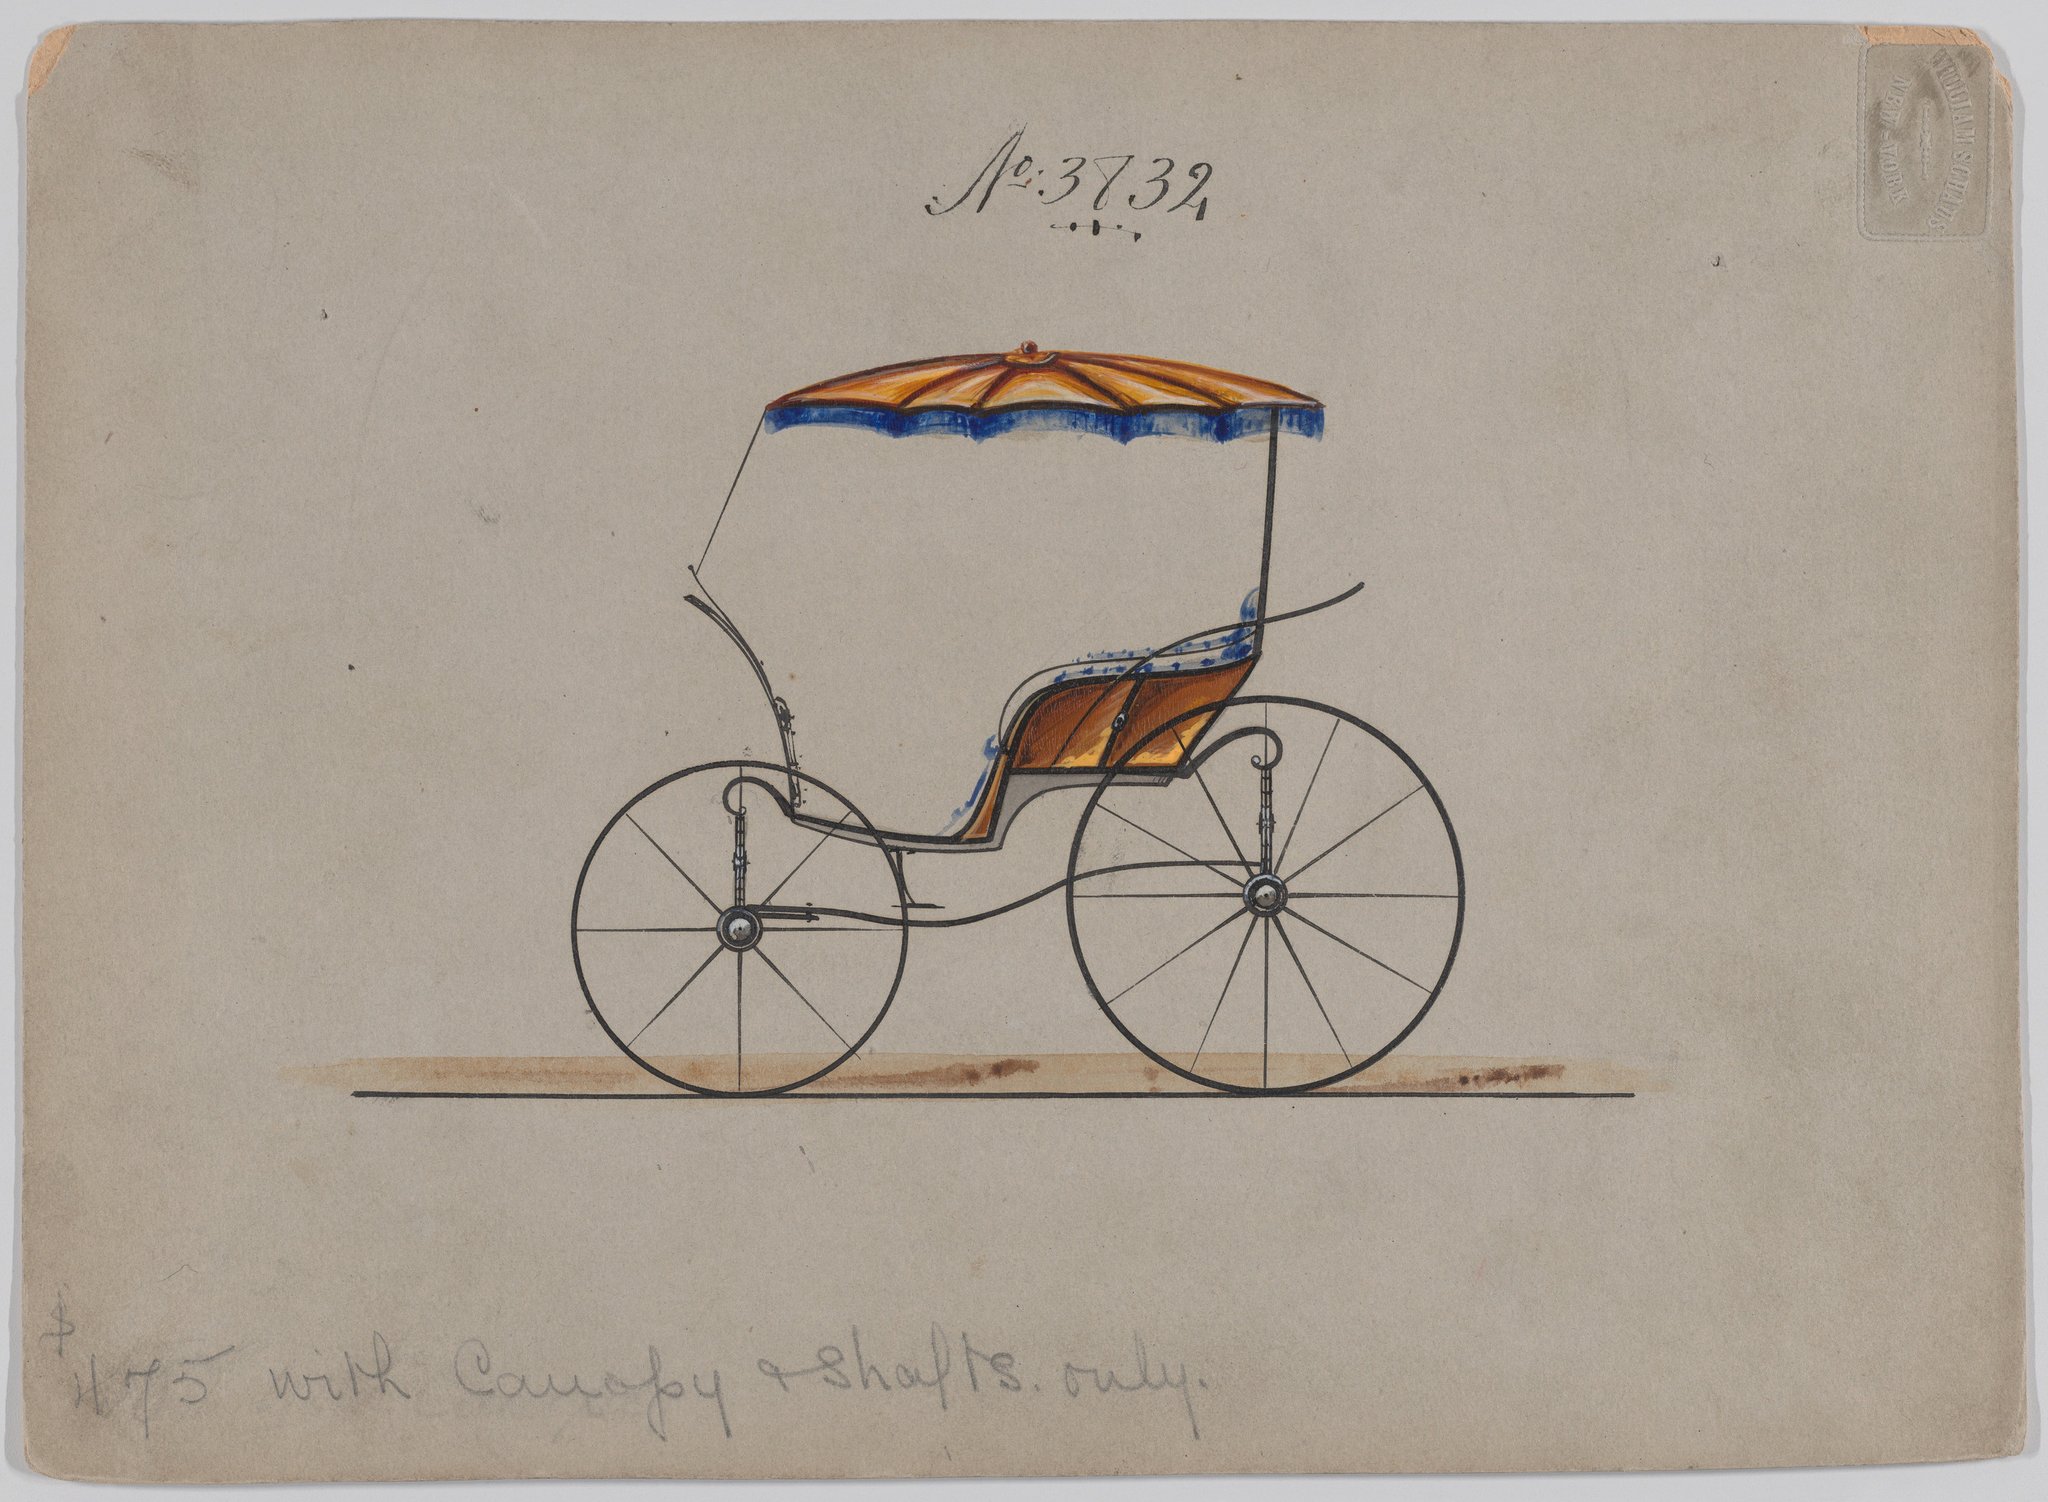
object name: drawing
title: Design for Pony Phaeton, no. 3832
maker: brewster & co.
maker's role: manufacturer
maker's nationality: american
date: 1883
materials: gouache, gum arabic, watercolor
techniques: pen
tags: carriages